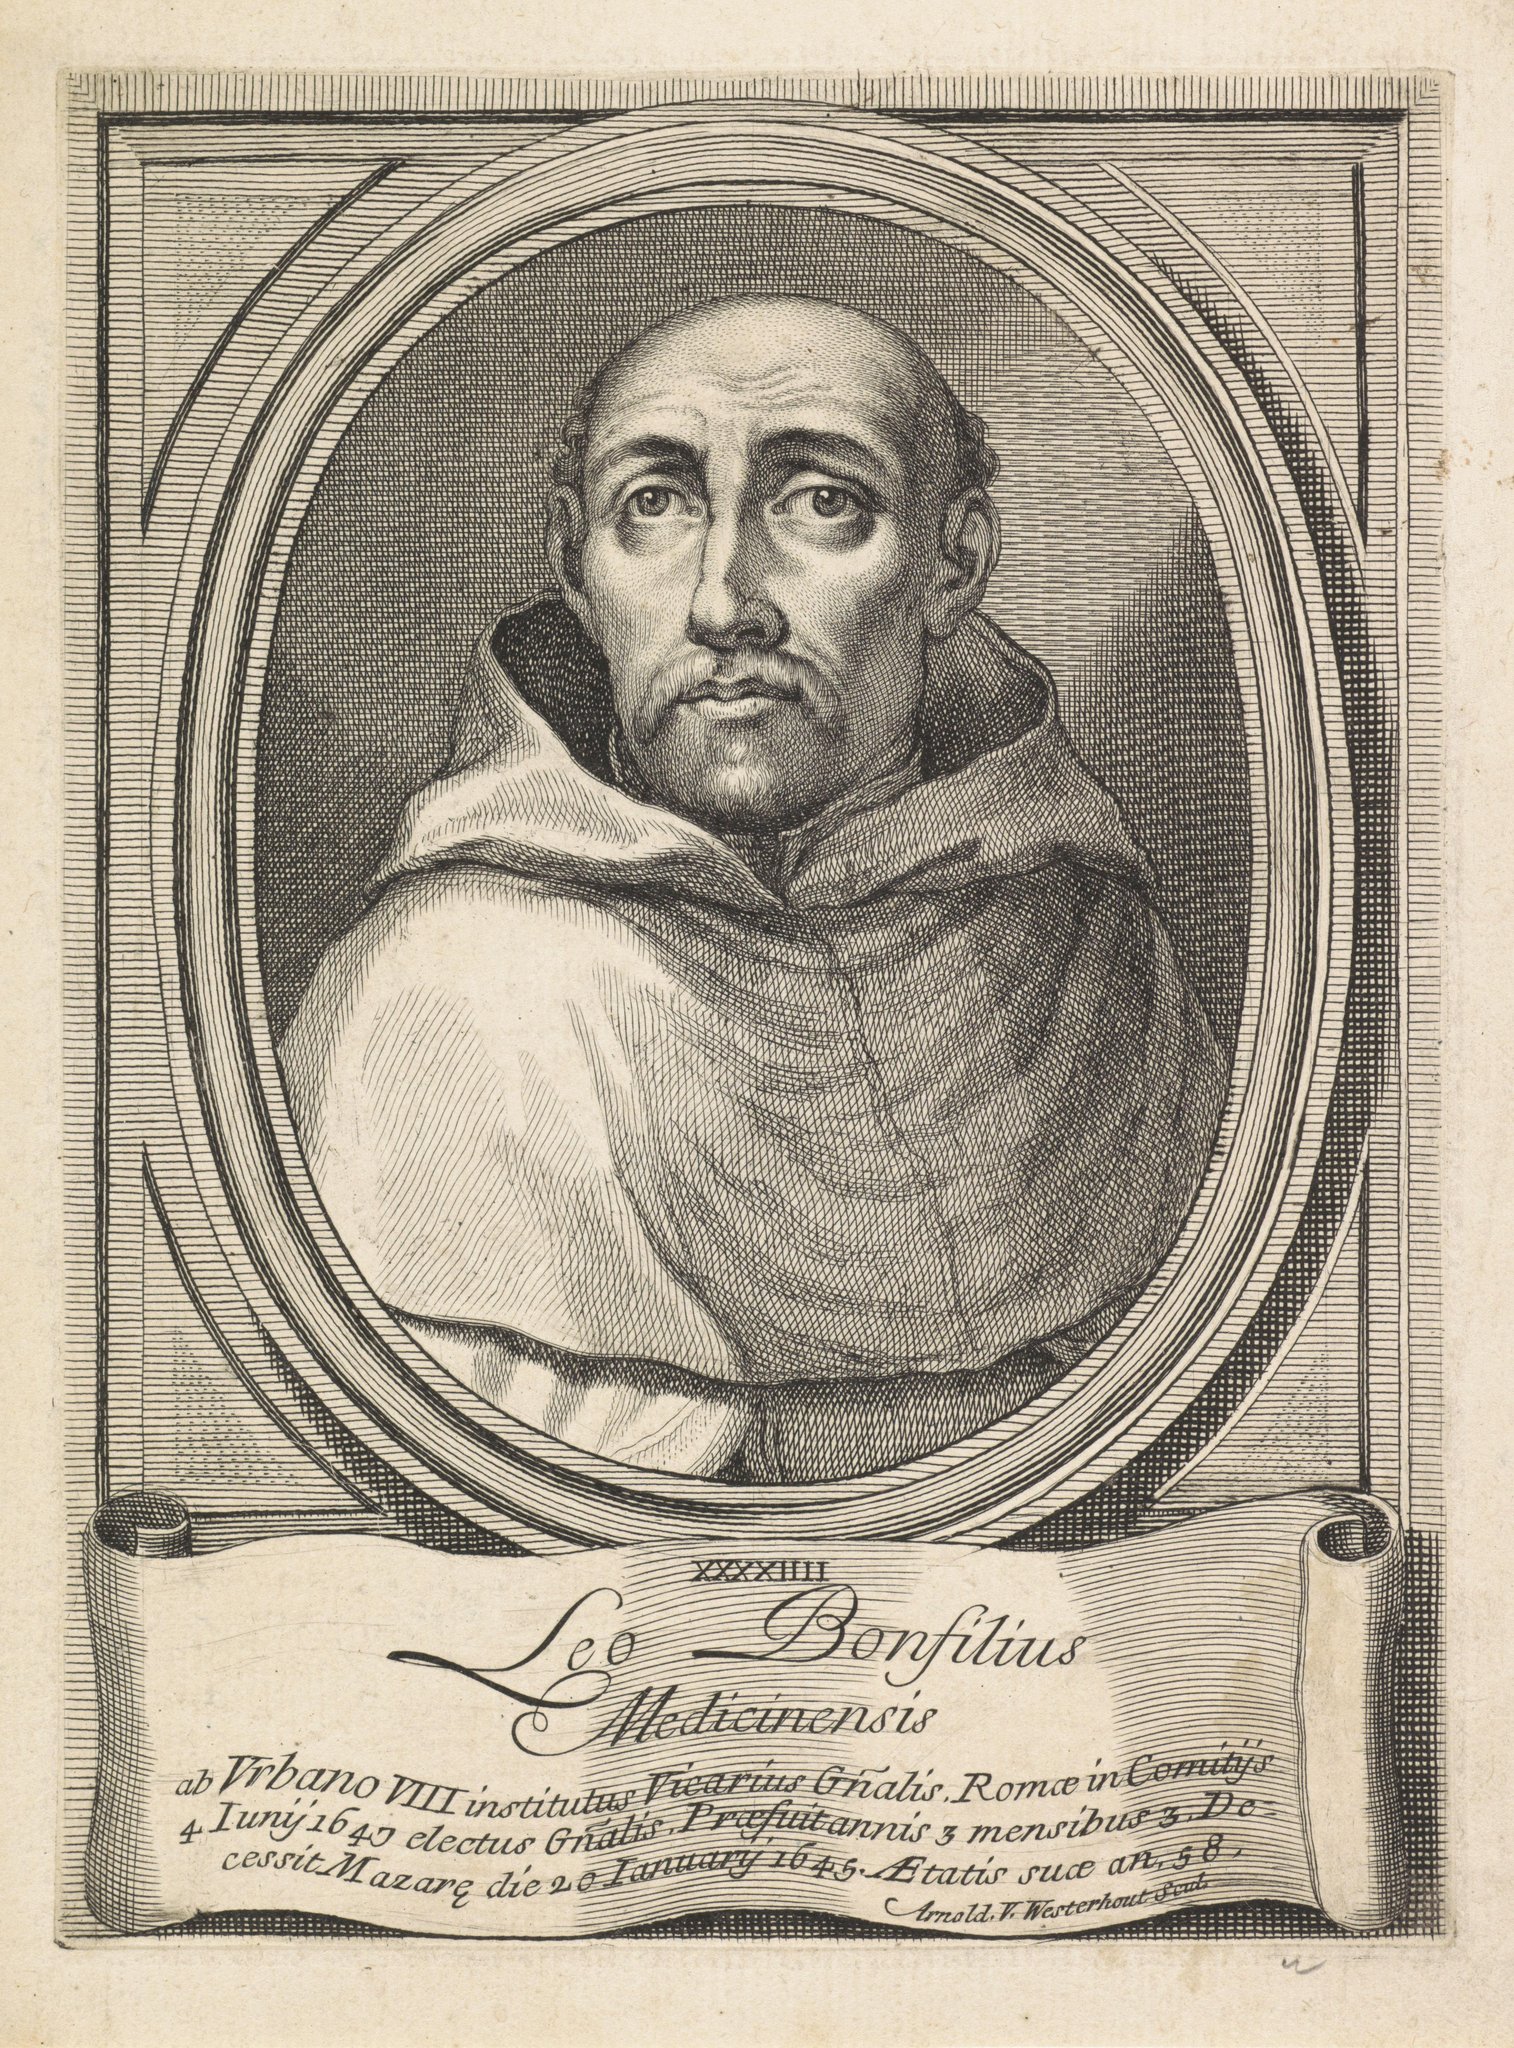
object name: print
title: Portret van Leo Bonfilius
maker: arnold van westerhout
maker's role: print maker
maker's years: 1651-1725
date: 1665-1725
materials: paper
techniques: engraving, etching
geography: italy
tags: leo bonfilius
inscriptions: collector's mark: Lugt 2228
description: Prent gebruikt in: Ventimiglia, Mariano. Historia chronologica priorum Generalium Latinorum Ordinis Beatissimae Virginis Mariae de Monte Carmelo. Napels: Simoniana, 1773.